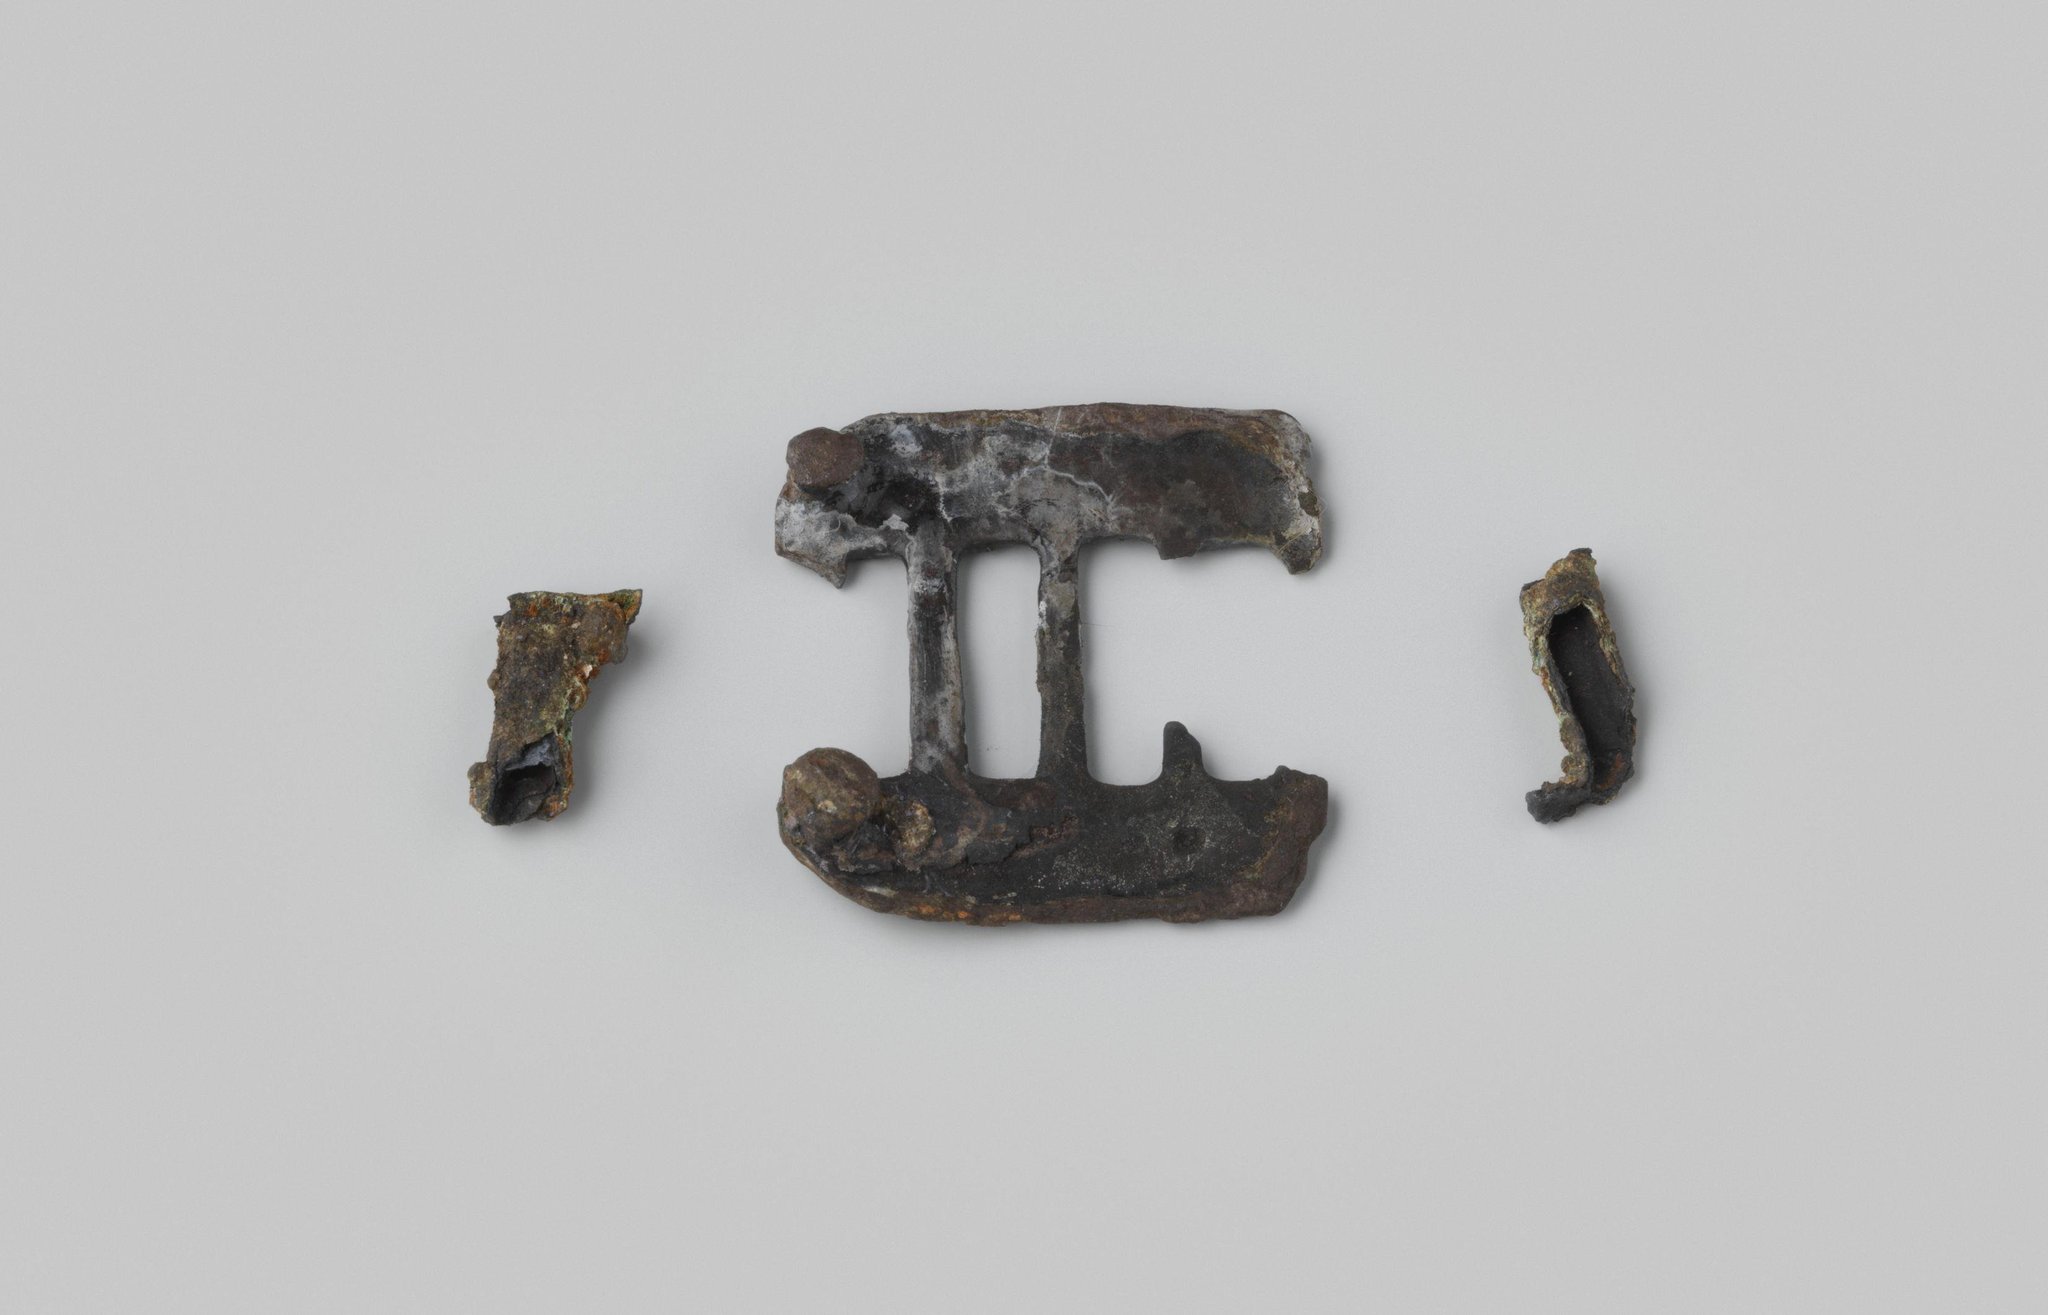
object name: clasp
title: Gefragmenteerde sluithaak uit het wrak van de Oost-Indiëvaarder Hollandia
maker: Anonymous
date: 1700-1743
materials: silver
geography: netherlands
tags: verenigde oostindische compagnie, hollandia (schip), annet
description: Locks, fastenings and accessories, clasp: fragm, eroded, sim. NG 1980-27H2438, one end missing, originally openwork centre with at least 4 openings, underneath one end 2 tenons or studs.